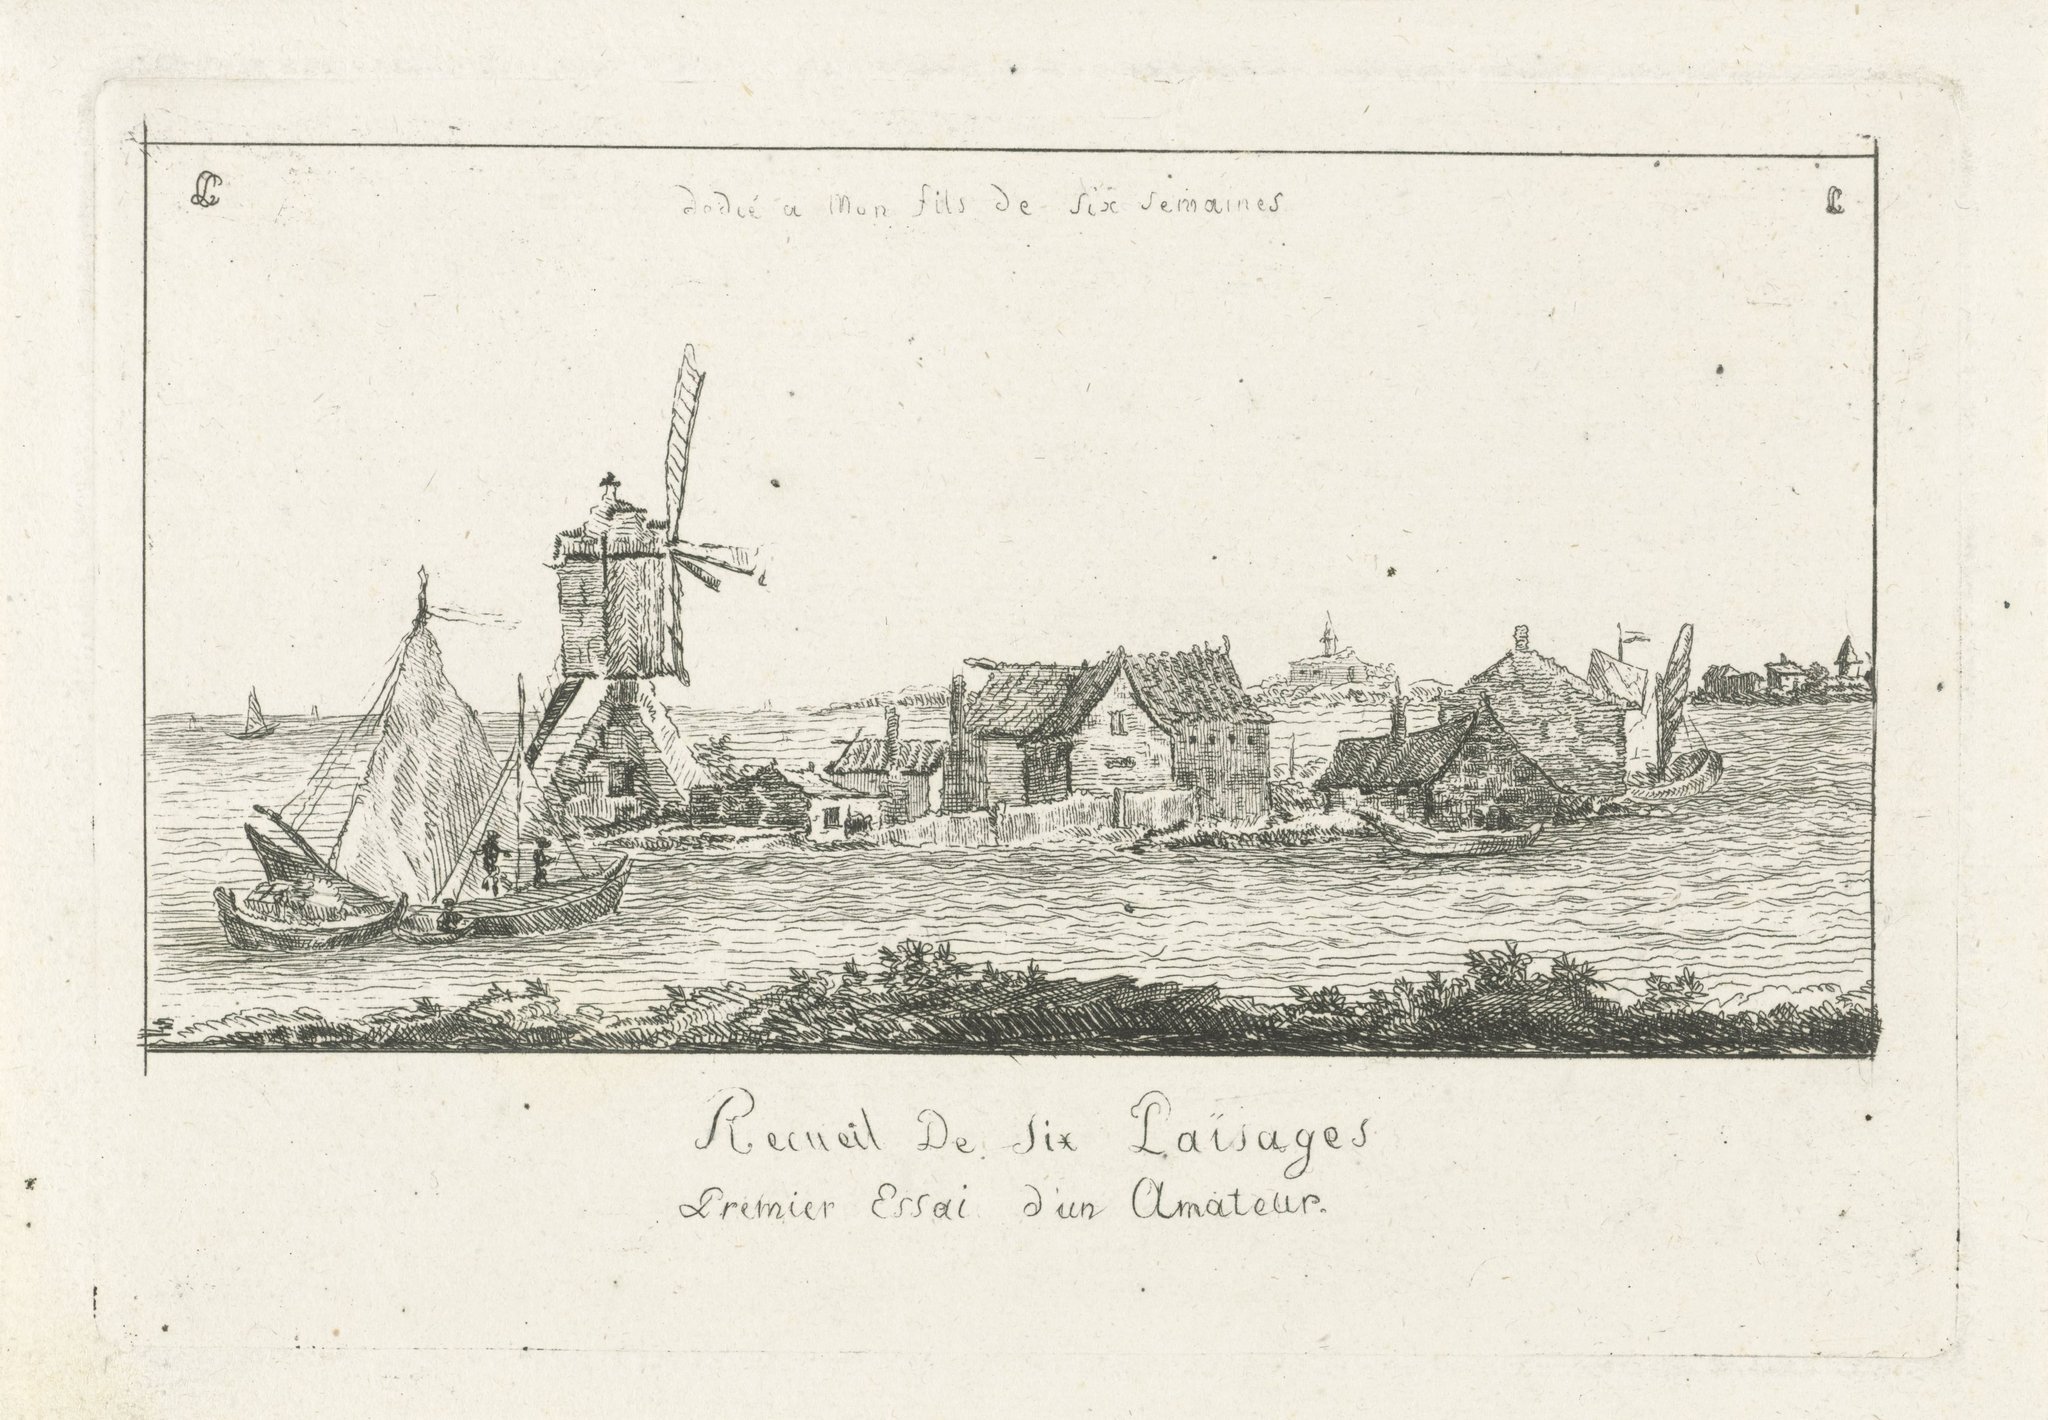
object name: print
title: Gezicht op een eiland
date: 1774-1792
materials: paper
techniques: etching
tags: island, landscapes with waters, waterscapes, seascapes (in the temperate zone)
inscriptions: collector's mark: Lugt 2228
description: Gezicht op een klein eiland waarop enkele huizen en een molen staan. Links vaart een aantal schepen.